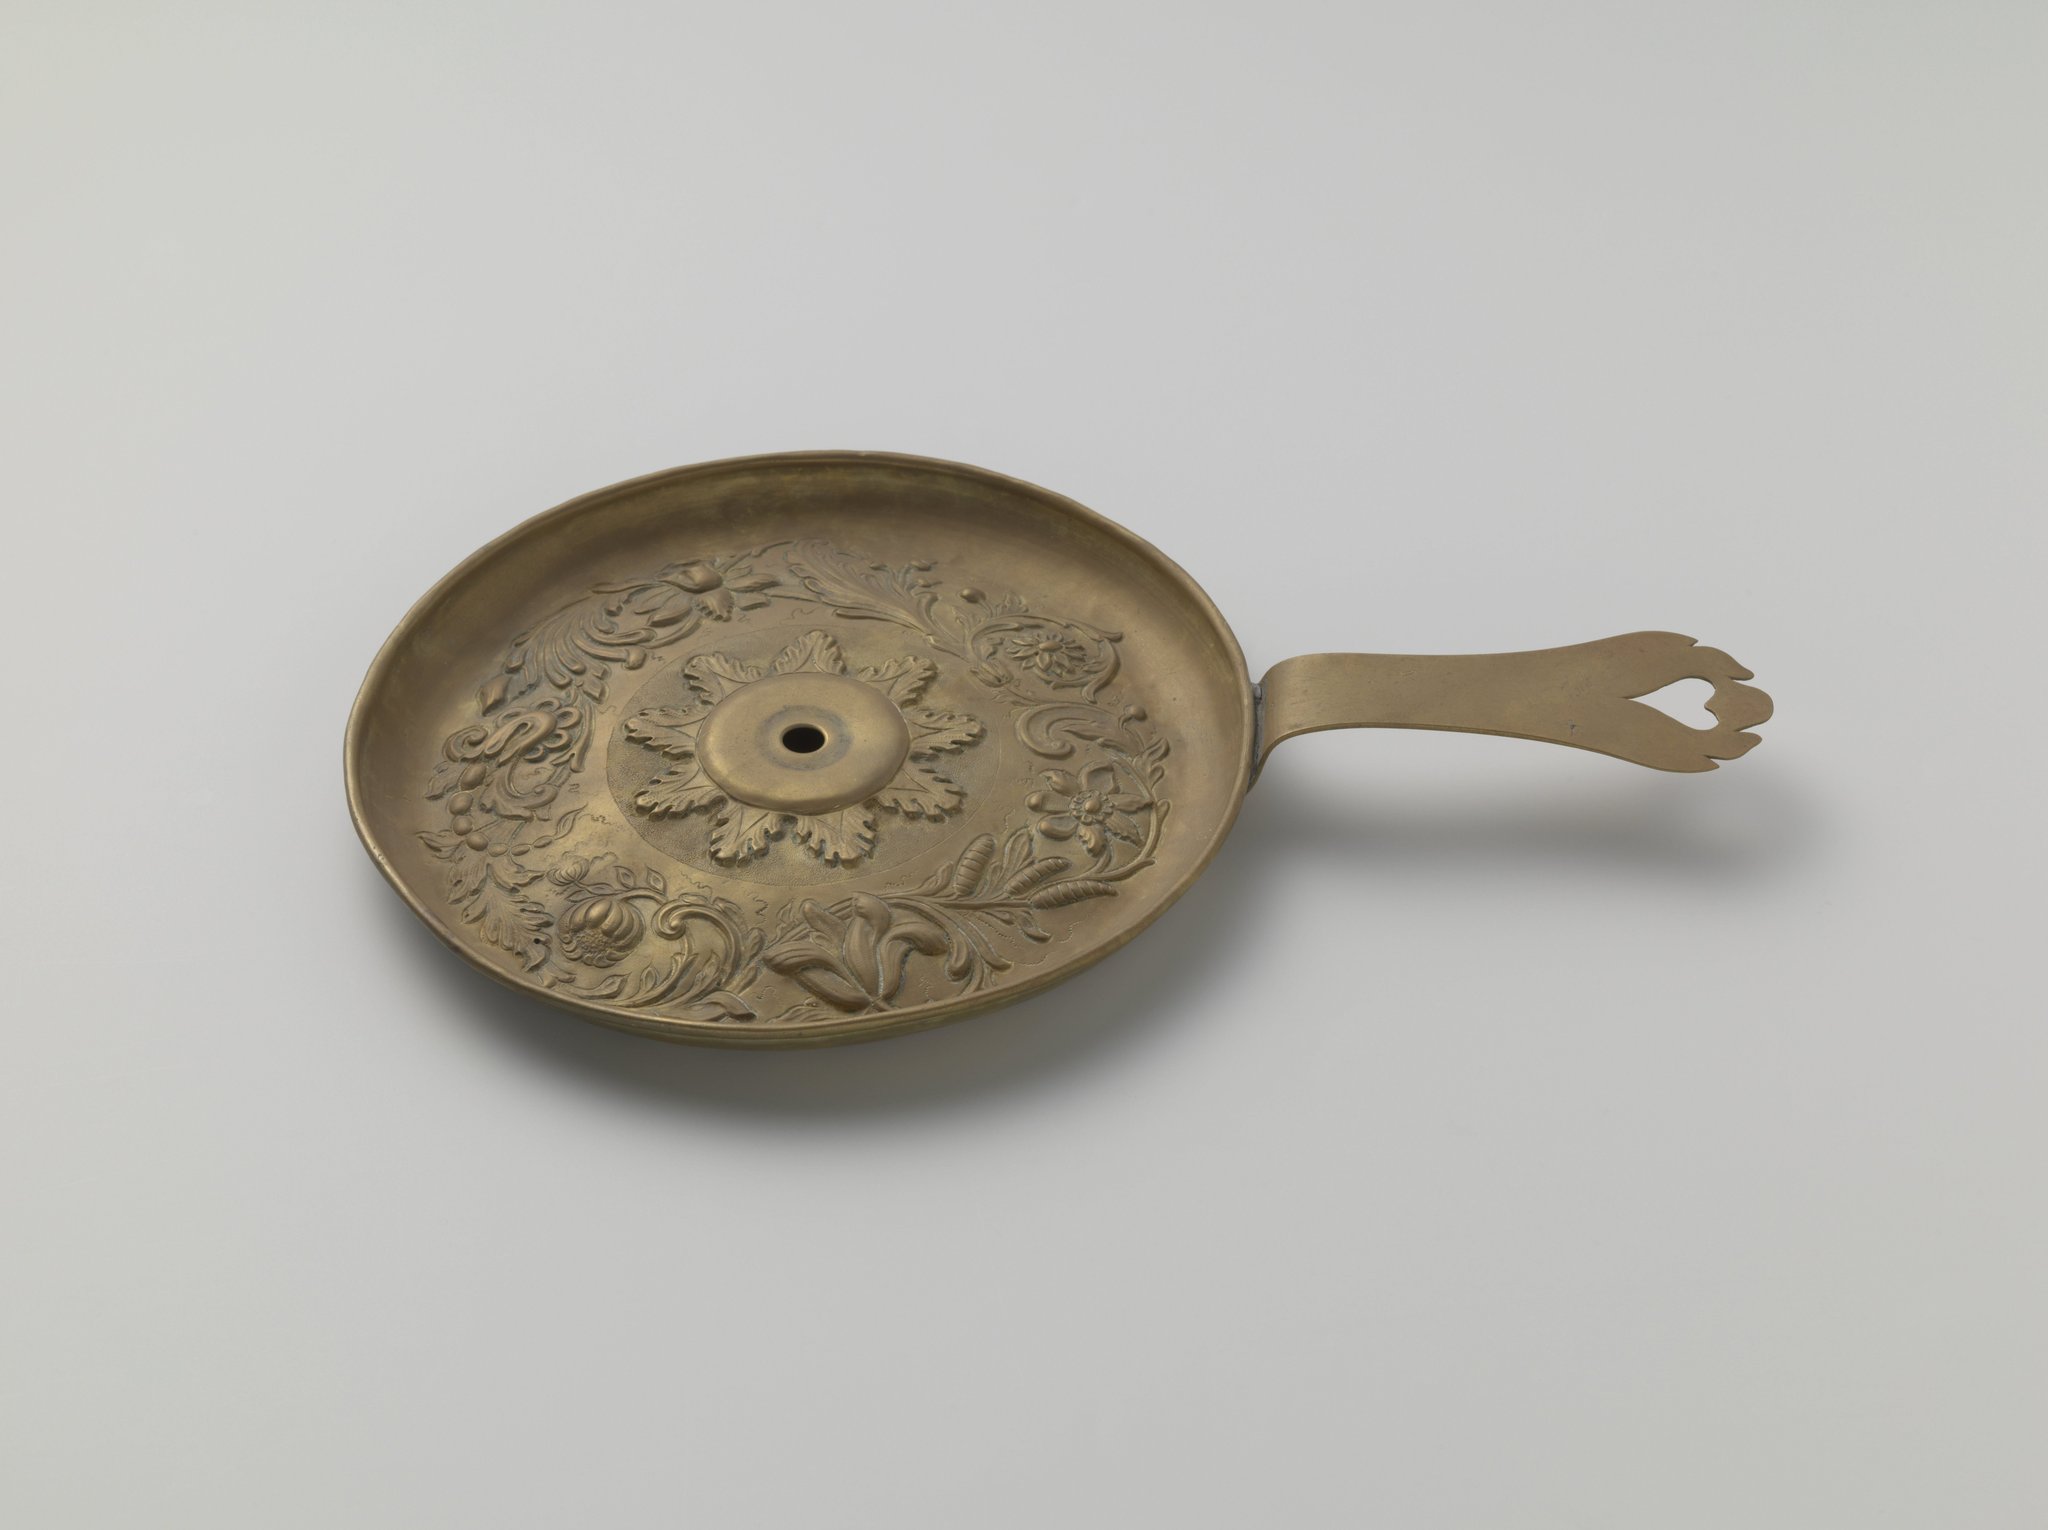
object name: chamberstick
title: Blaker van messing met rankenornament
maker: Anonymous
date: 1600-1699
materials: brass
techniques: repoussé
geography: mechelen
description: Het voorwerp bestaat uit een ronde vetvanger met gedreven rankenornament met bloemen en vruchten, en acanthusbladeren rond de aanzet tot de kaarsenhouder. De steel heeft een hartvormig oog en een getand uiteinde. De kaarsenhouder ontbreekt.